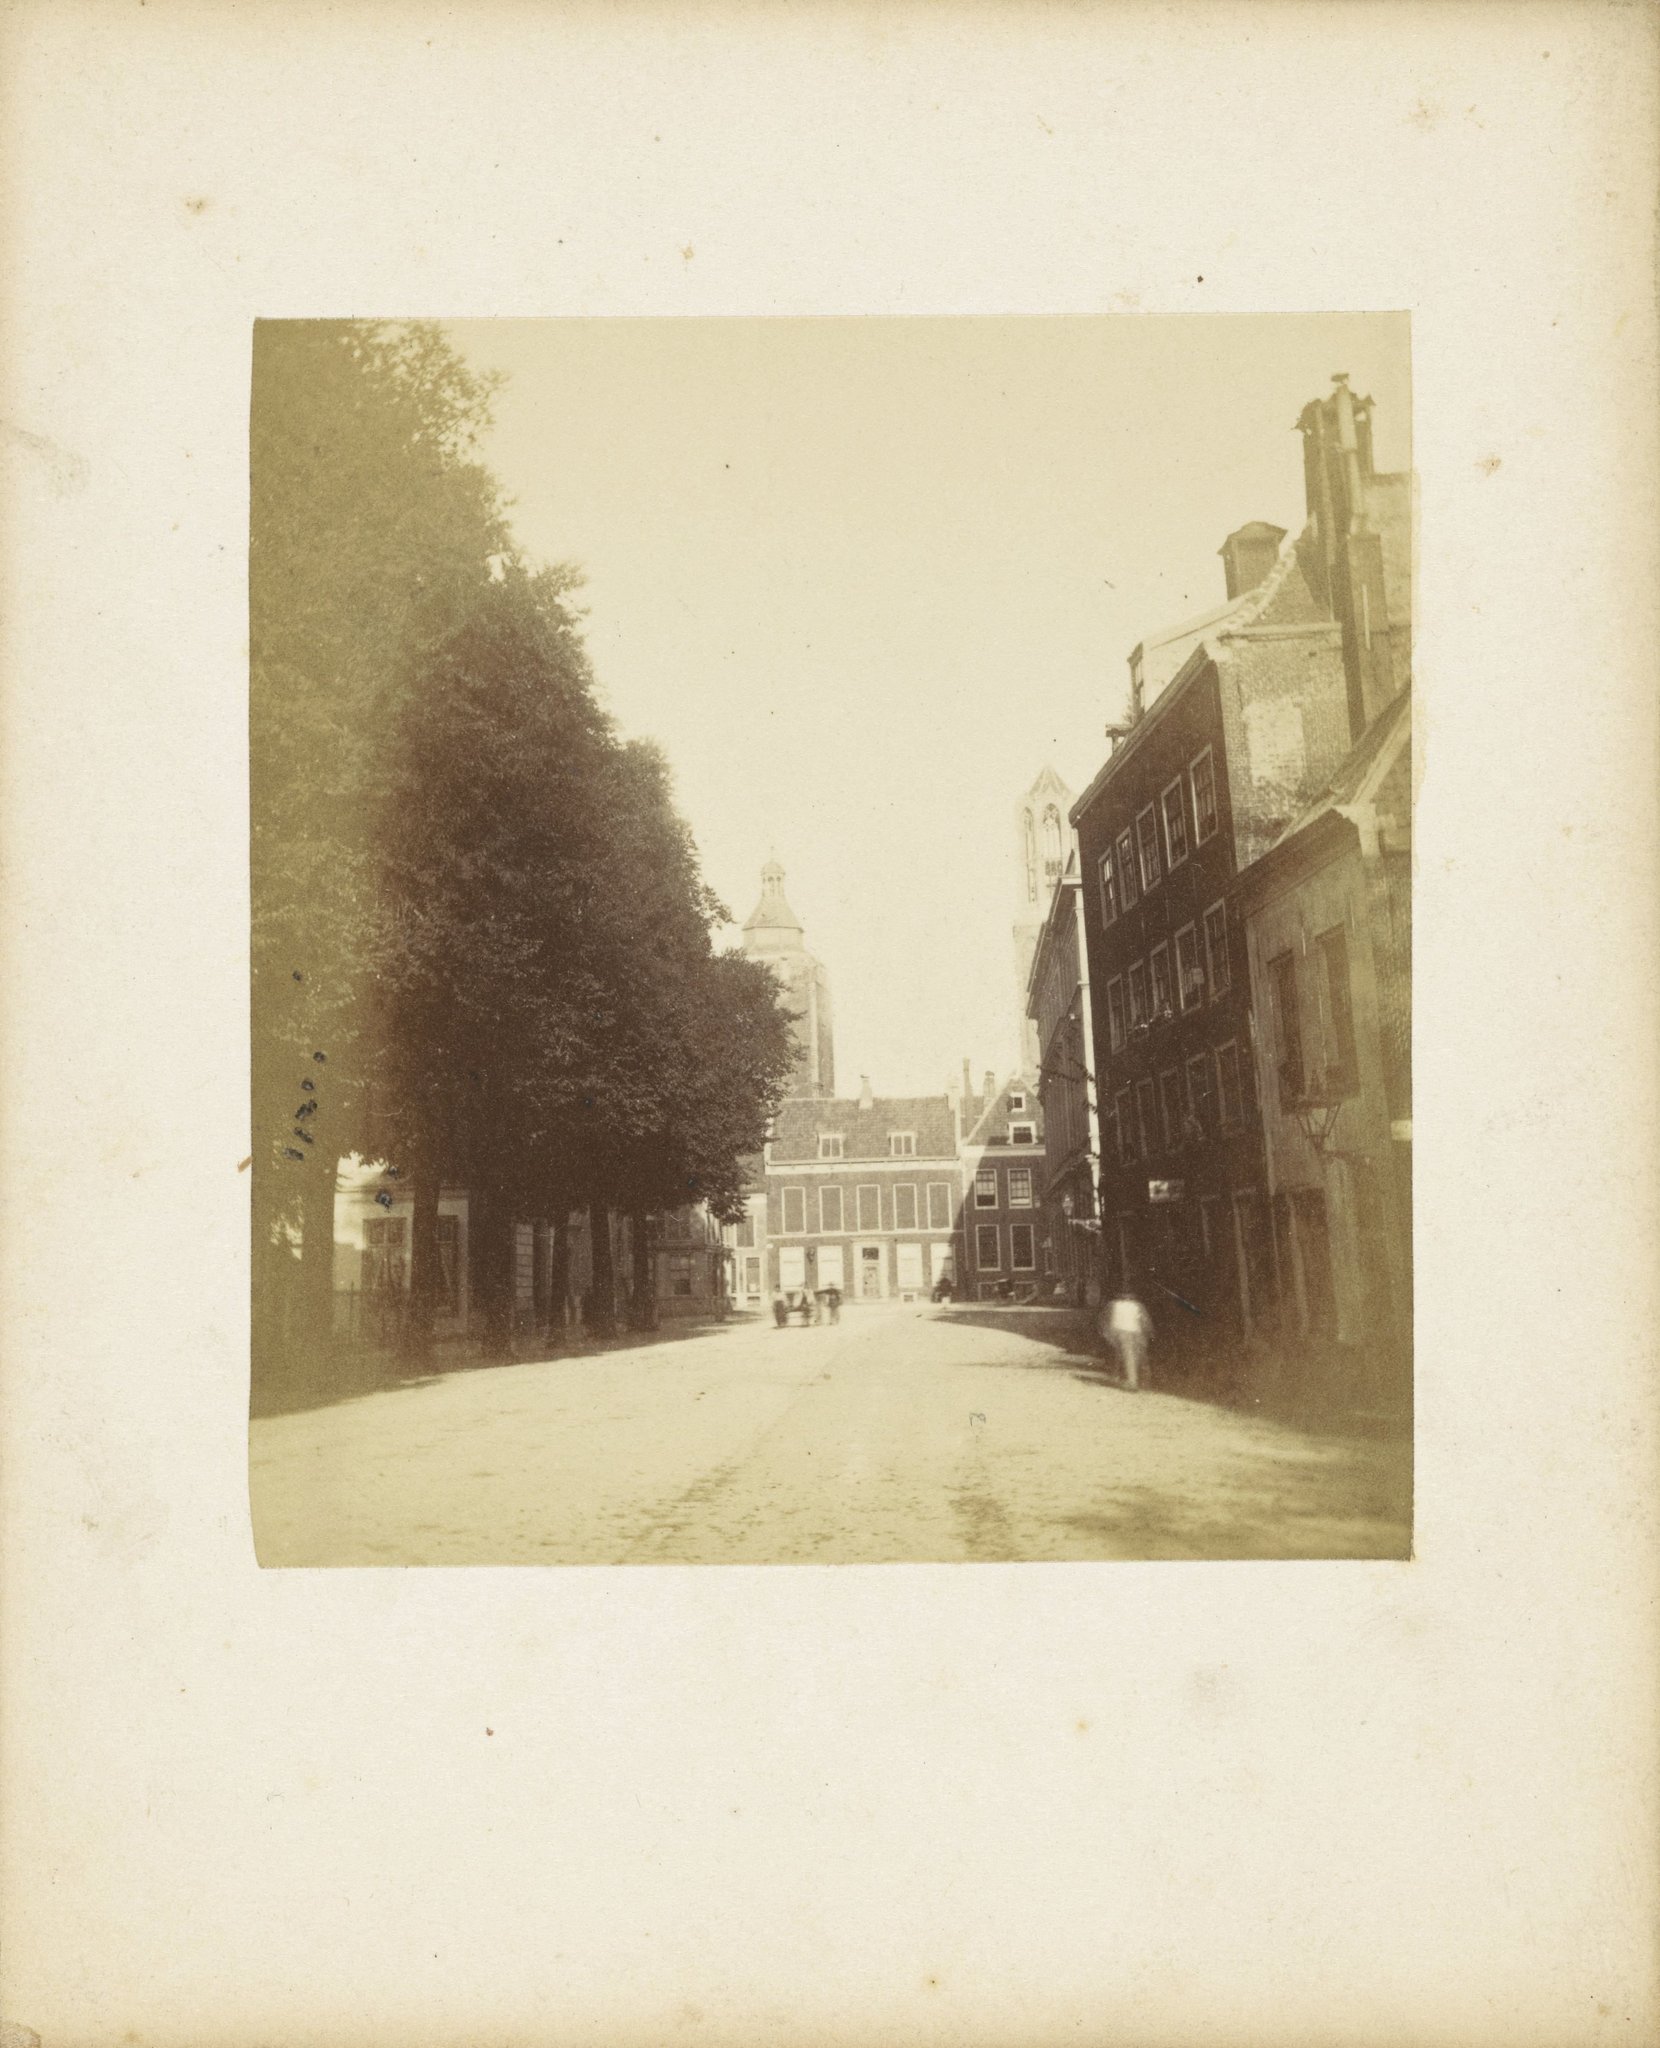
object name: photograph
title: Brede straat met hoge bomen in Utrecht, met op de achtergrond de Buurkerk (links) en de Domtoren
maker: Anonymous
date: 1855-1860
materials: cardboard, photographic support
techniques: albumen print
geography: utrecht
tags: street (+ city(-scape) with figures, staffage), parts of church exterior and annexes: tower, utrecht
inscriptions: inscription: ‘Utrecht’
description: Foto hoort bij een serie van twaalf foto’s die mogelijk ooit als leporelloalbum aan elkaar hebben gezeten (foto's RP-F-F00929-A t/m L).